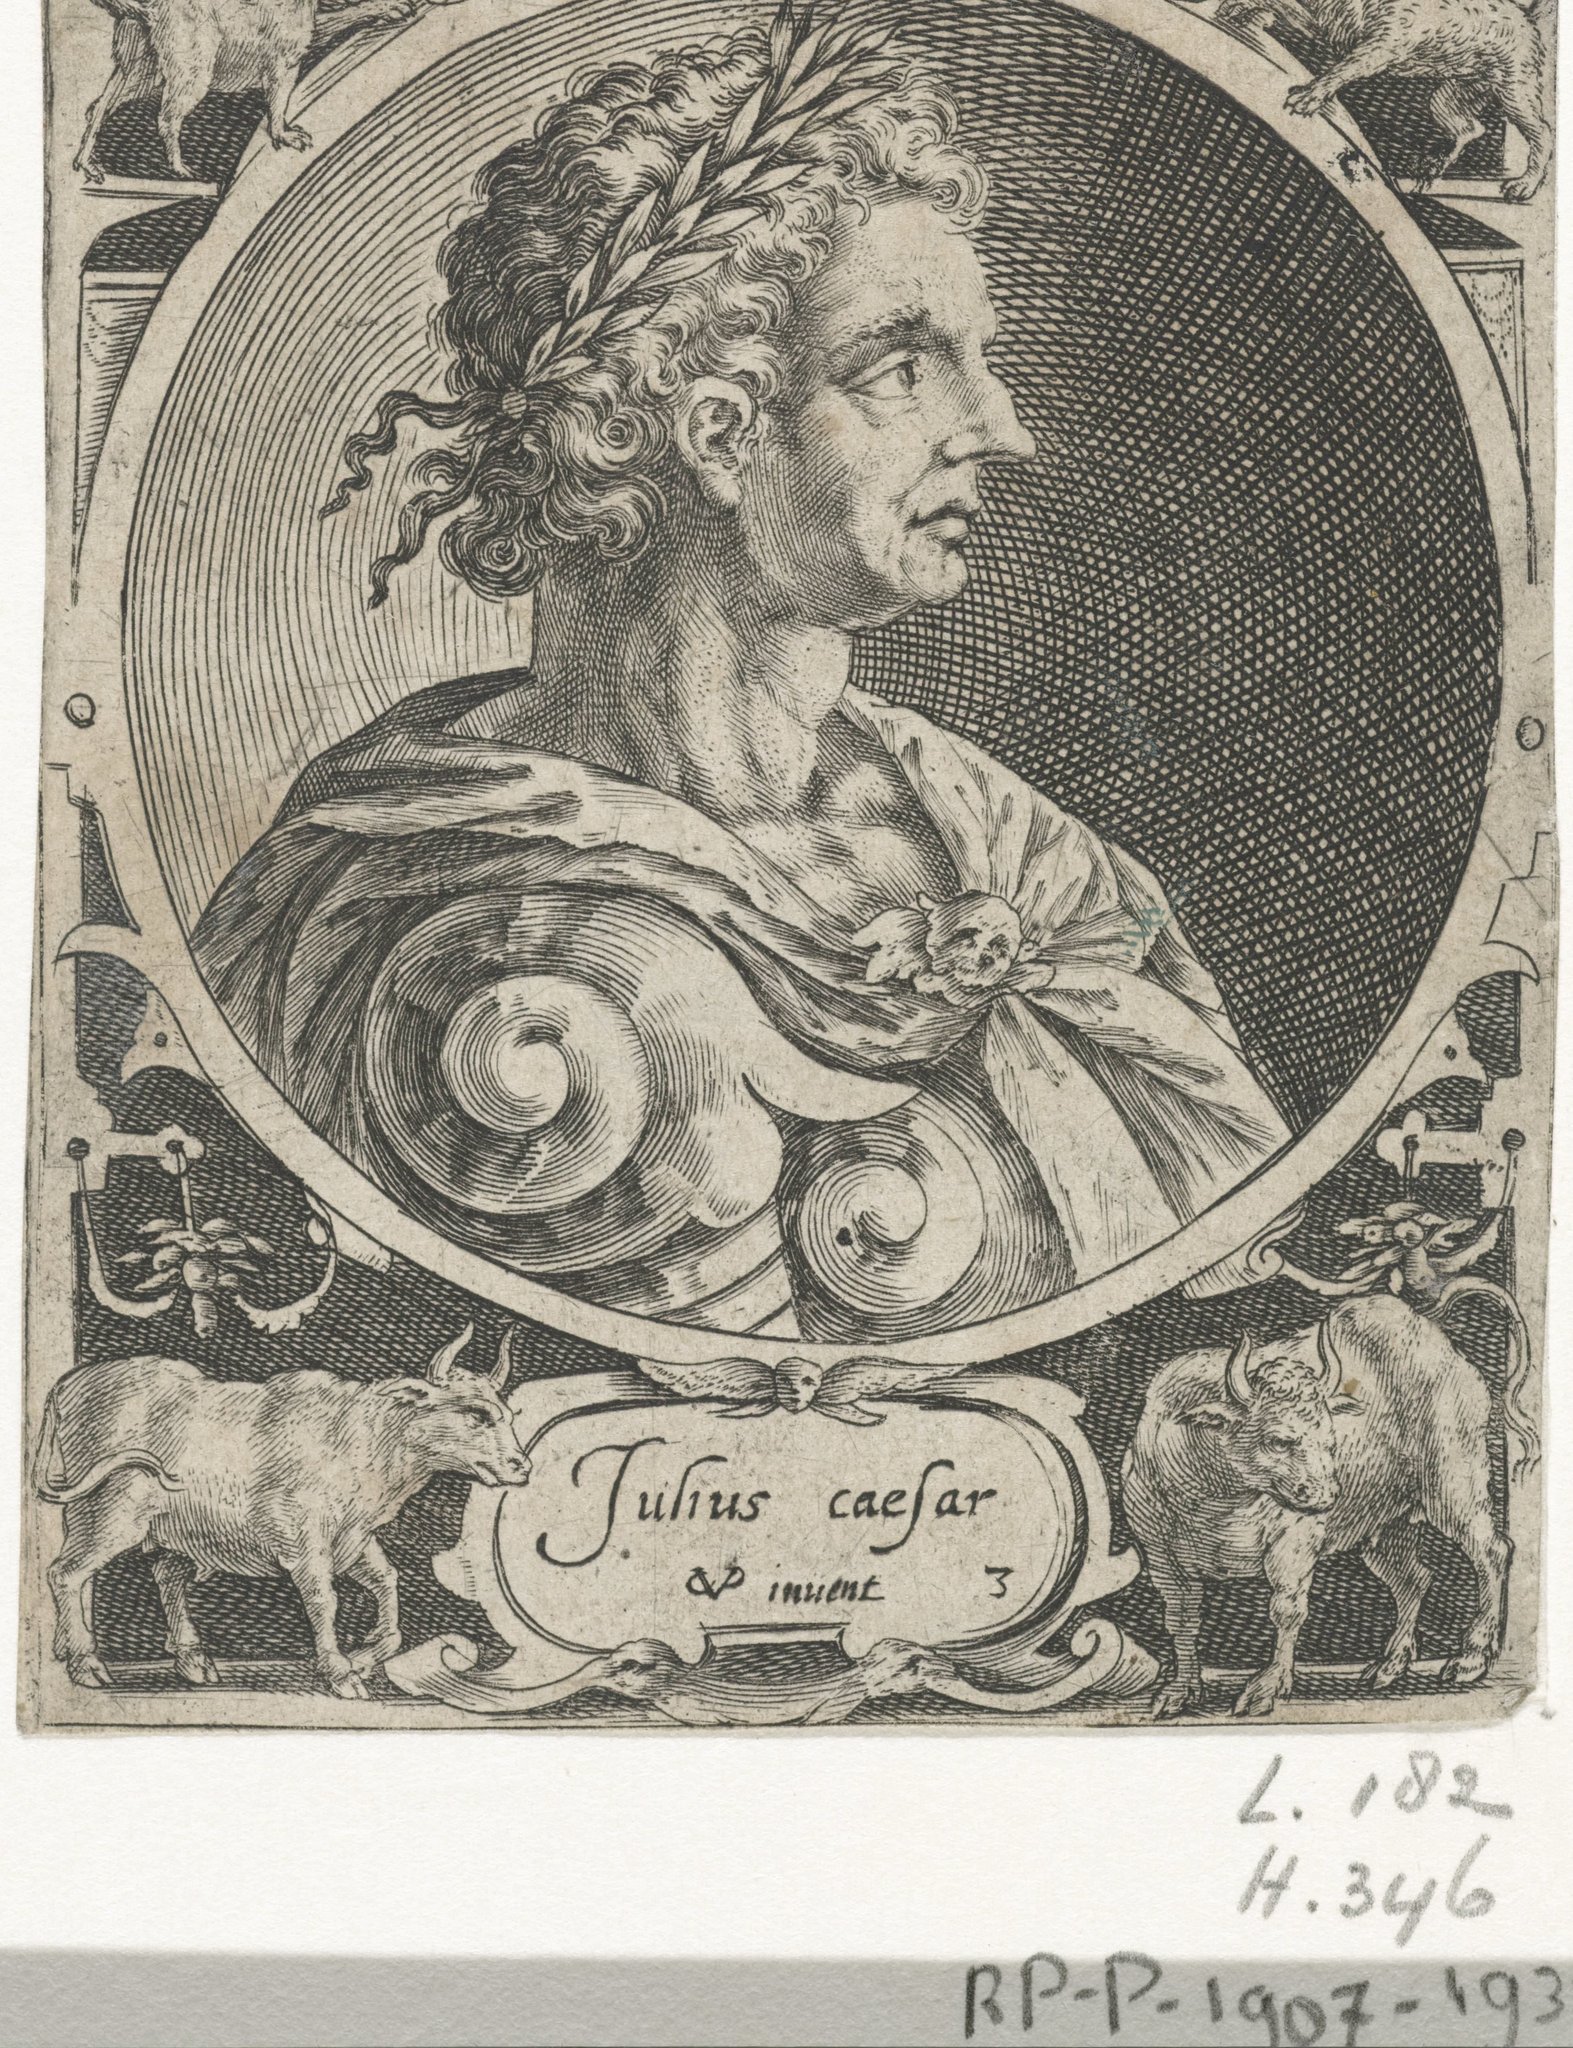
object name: print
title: Julius Caesar als een van de negen helden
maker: crispijn van de passe (i)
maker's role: draughtsman, print maker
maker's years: 1564-1637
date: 1574-1637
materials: paper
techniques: engraving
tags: rome, julius caesar (one of the nine worthies)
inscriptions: collector's mark: Lugt 2228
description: De held uit de klassieke oudheid Julius Caesar. Buste gevat in een medaillon met daaronder een cartouche met zijn naam. In de onderhoeken twee stieren en in de bovenhoeken twee honden. Prent uit een serie van negen met helden.